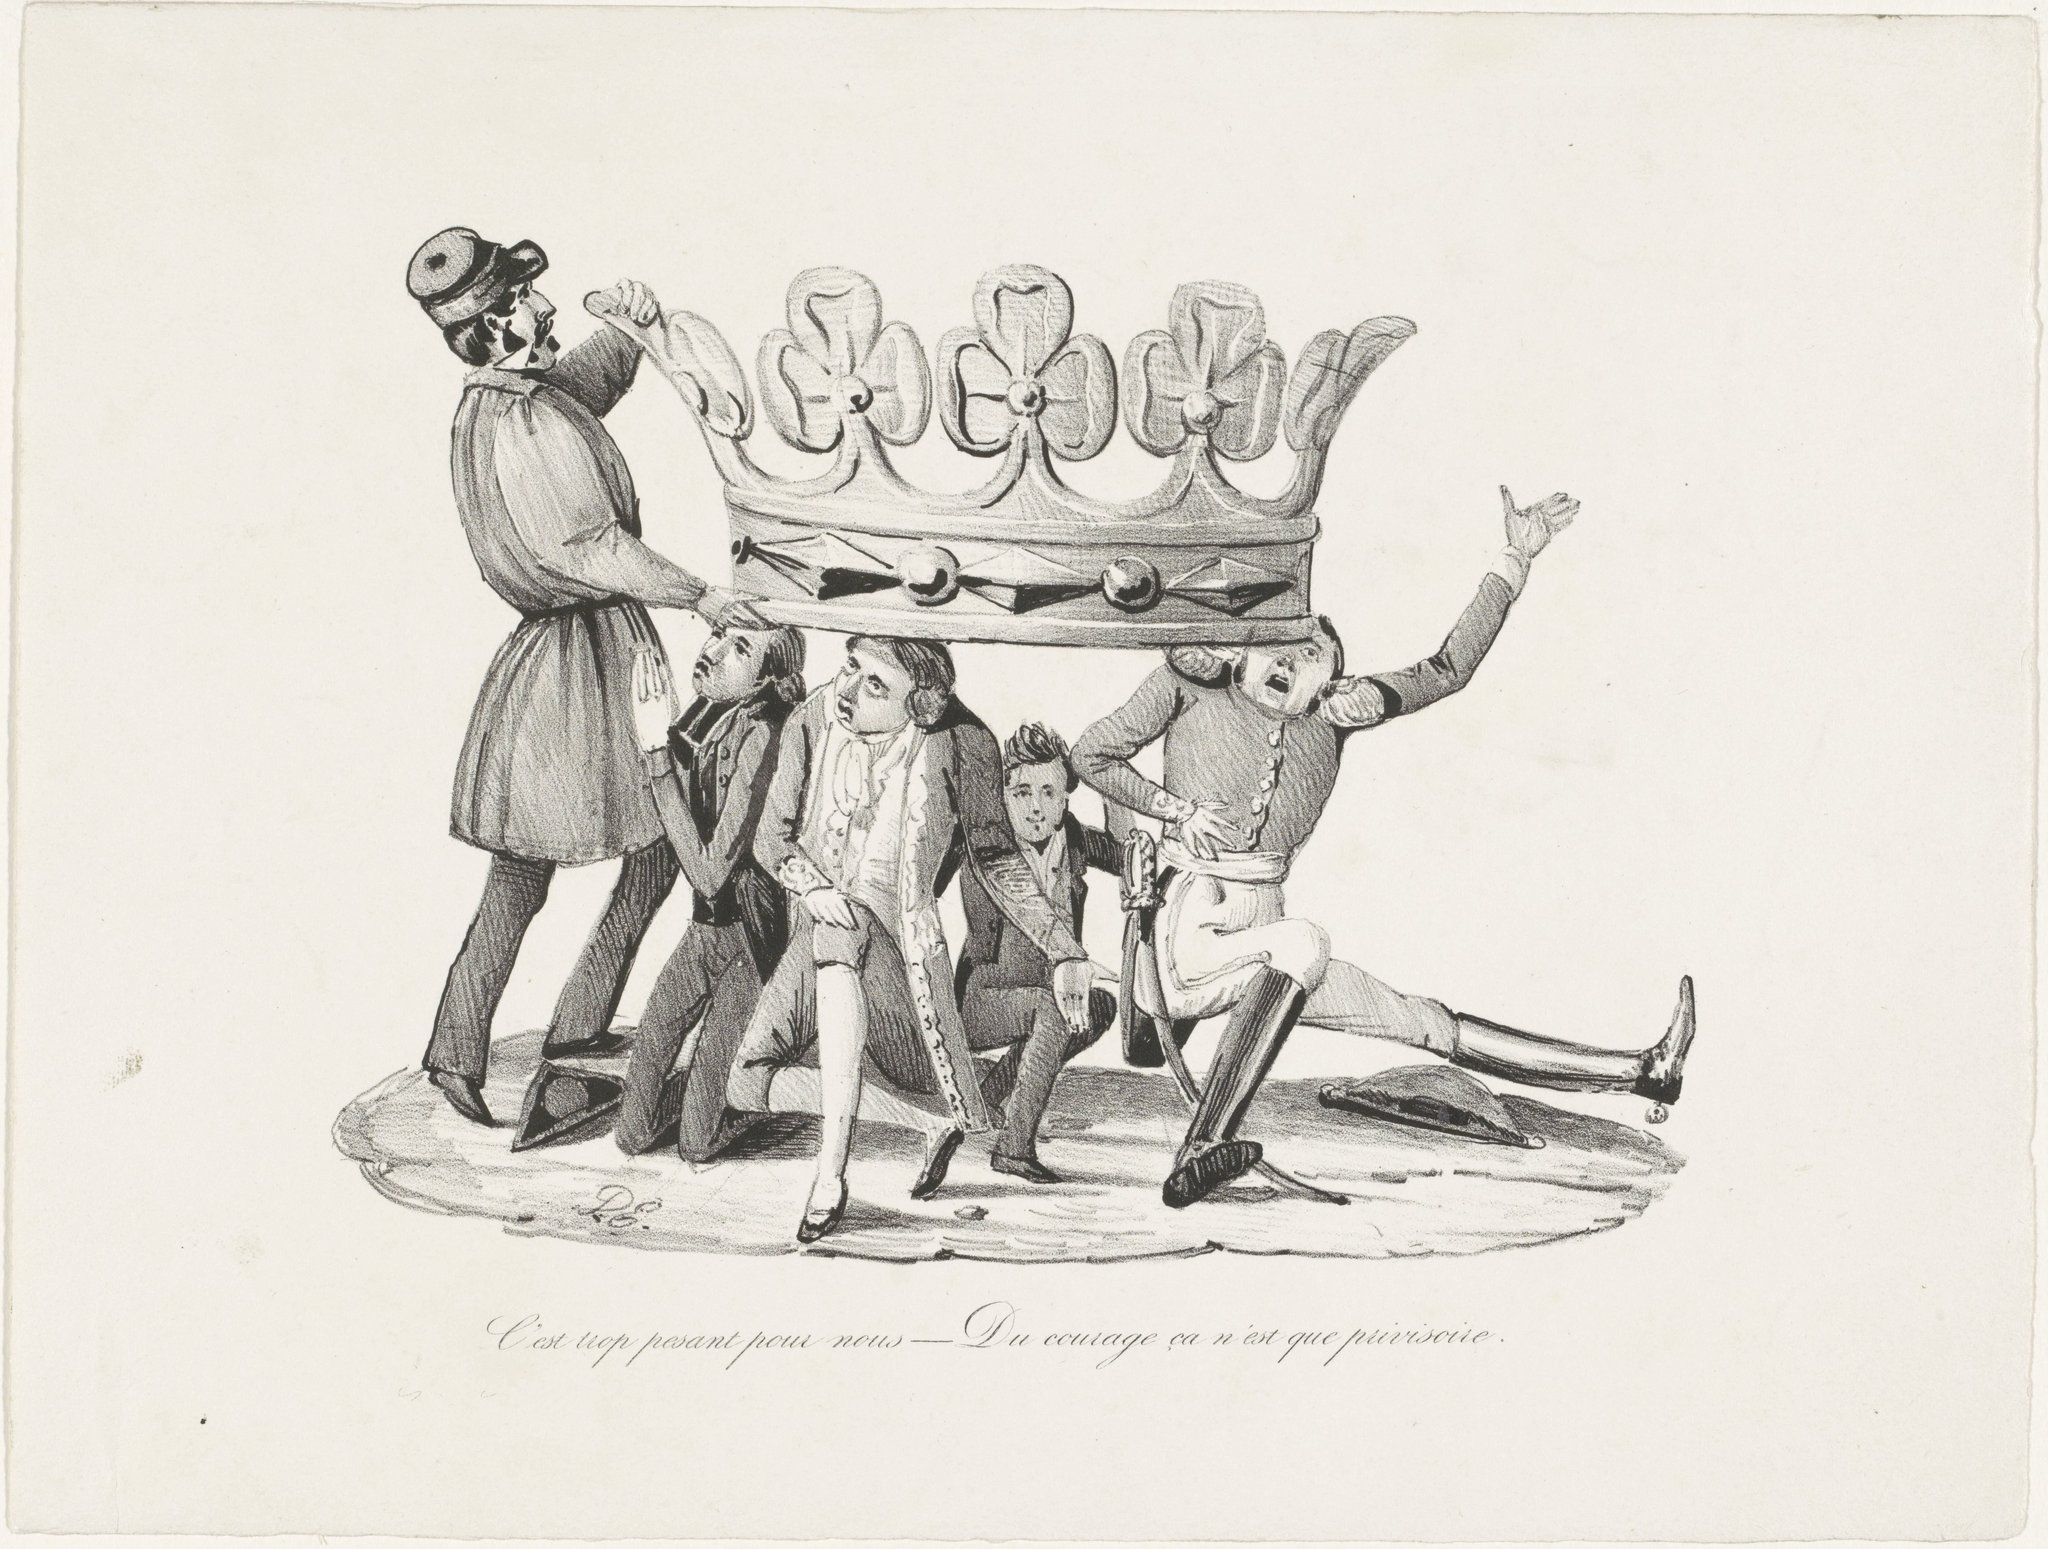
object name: print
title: Spotprent op de leden van het Voorlopig Bewind, 1830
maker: monogrammist de (belgië)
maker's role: lithograaf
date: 1830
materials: paper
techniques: lithograph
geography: belgium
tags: bruges, politician, crown (symbol of sovereignty), revolutionary government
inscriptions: collector's mark: Lugt 2228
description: Spotprent op de leden van het Voorlopig Bewind van België in 1830. Een Belgische vrijwilliger plaatst de kroon op de hoofden van drie leden van de voorlopige regering die haast bezwijken onder de zware last. Een vierde man vermijdt glimlachend het dragen van de last van de kroon.